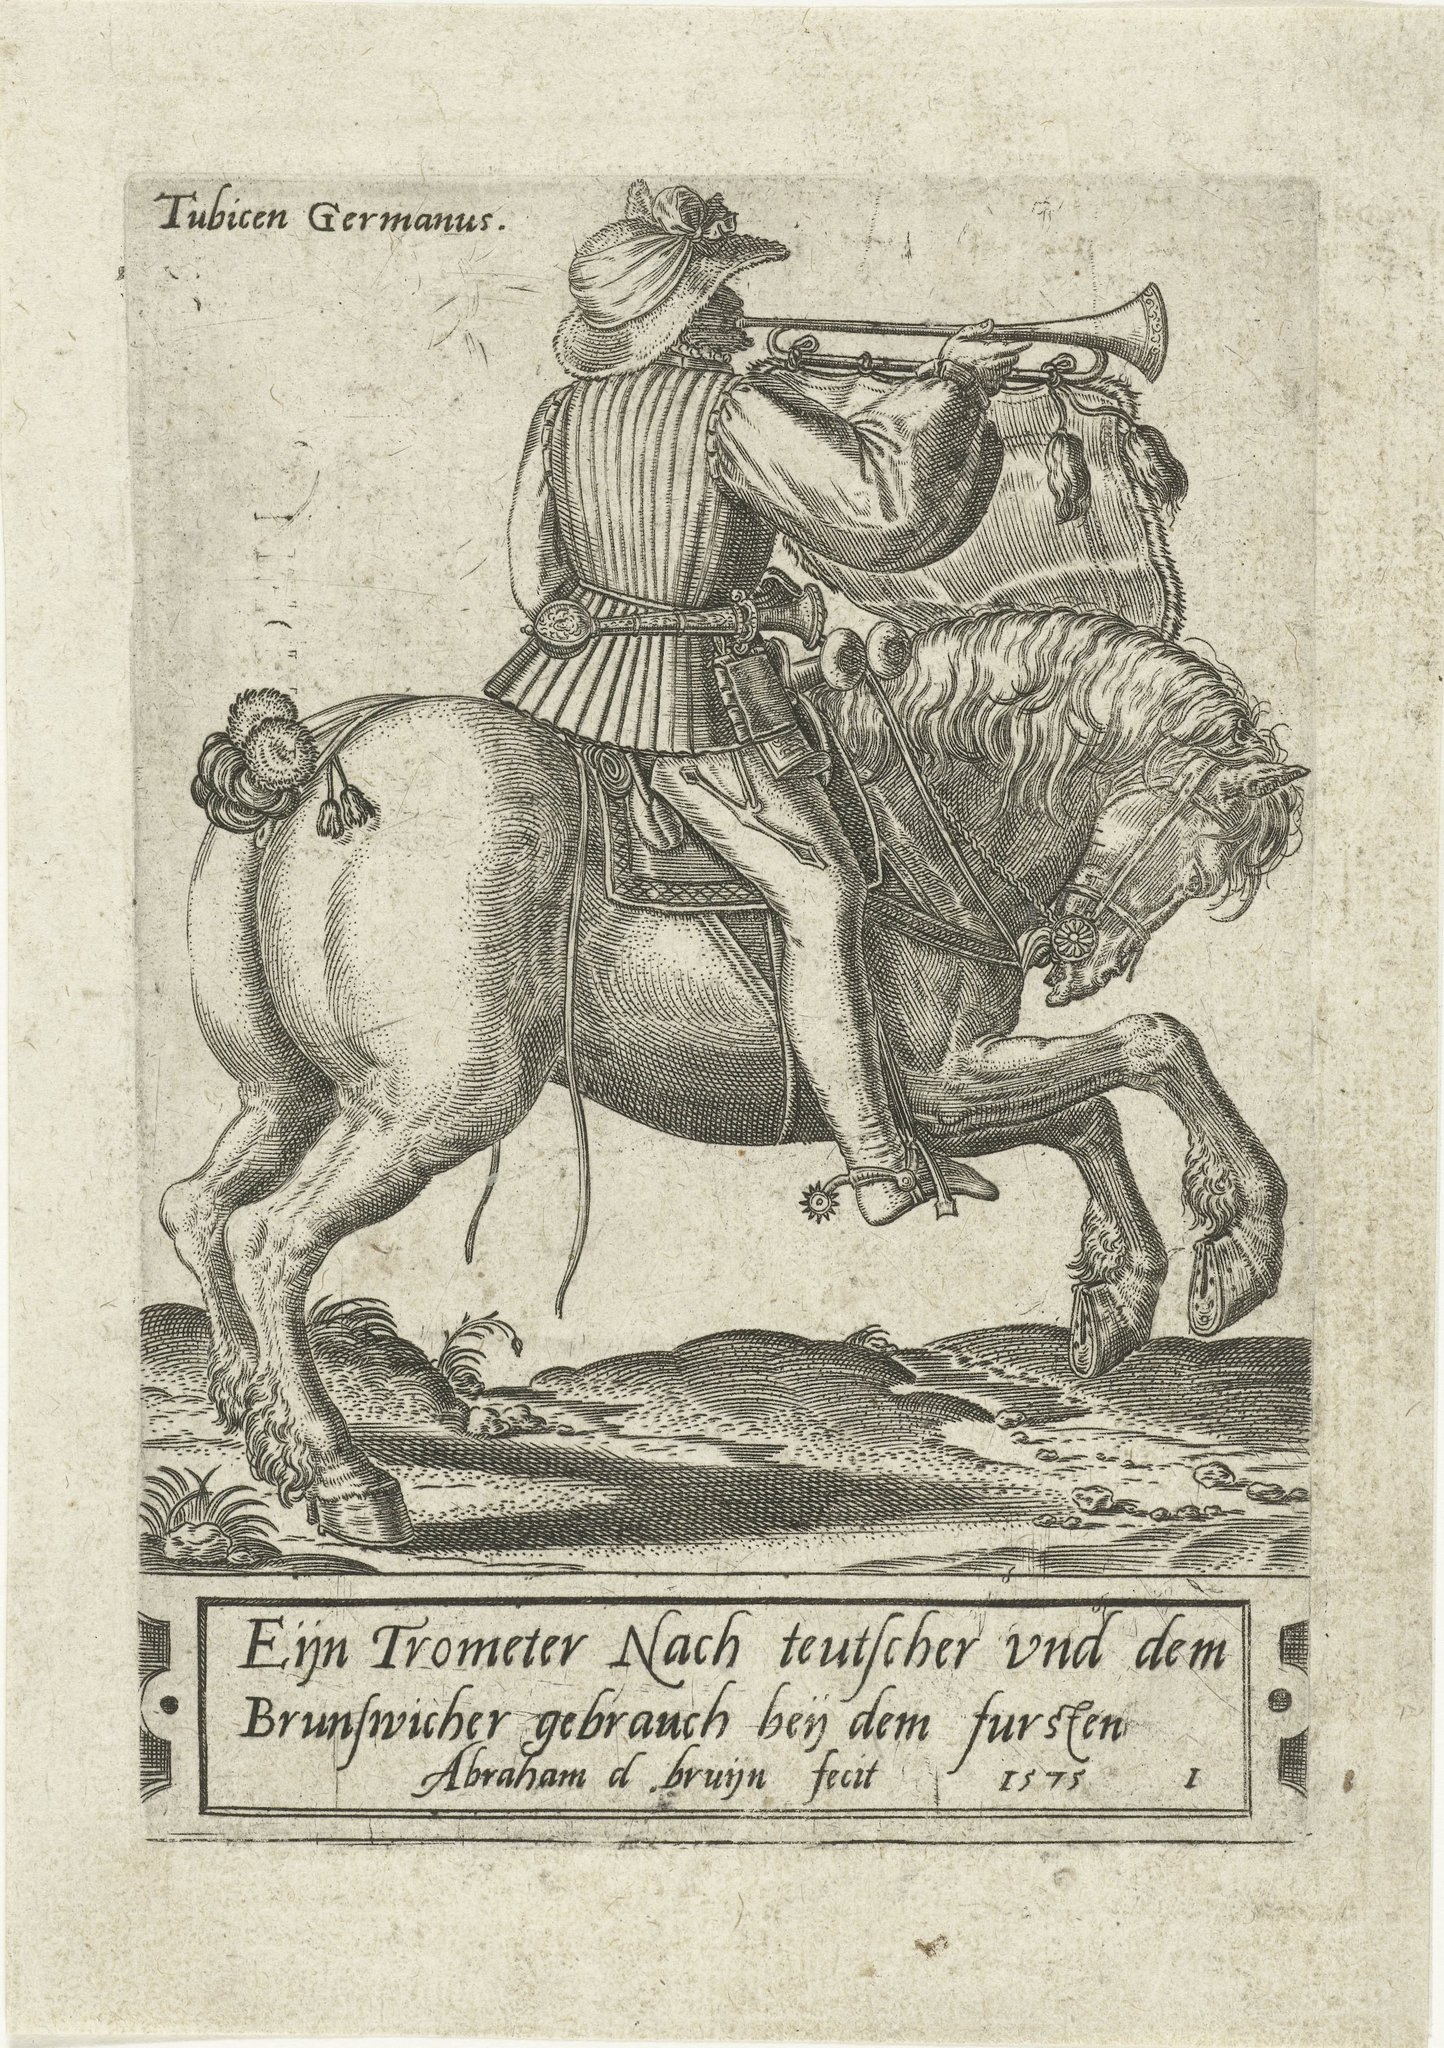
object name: costume print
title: Duitse ruiter met hoorn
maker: abraham de bruyn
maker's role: print maker, publisher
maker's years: 1540-1587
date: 1575-1577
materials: paper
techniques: engraving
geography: cologne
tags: one person playing wind instrument, warfare; military affairs (+ cavalry, horsemen), folk costume, regional costume, military clothing and other equipment (uniforms, cap, armour, helmet, etc.), europeans: germans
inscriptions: collector's mark: Lugt 2228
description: Paard en ruiter naar rechts. Het paard is in galop terwijl de ruiter, op zijn Duits gekleed, zijn hoorn blaast. De prent heeft een Duits onderschrift en een Latijns bovenschrift. Prent oorspronkelijk uit 'Equitum descripcio...', 1577.